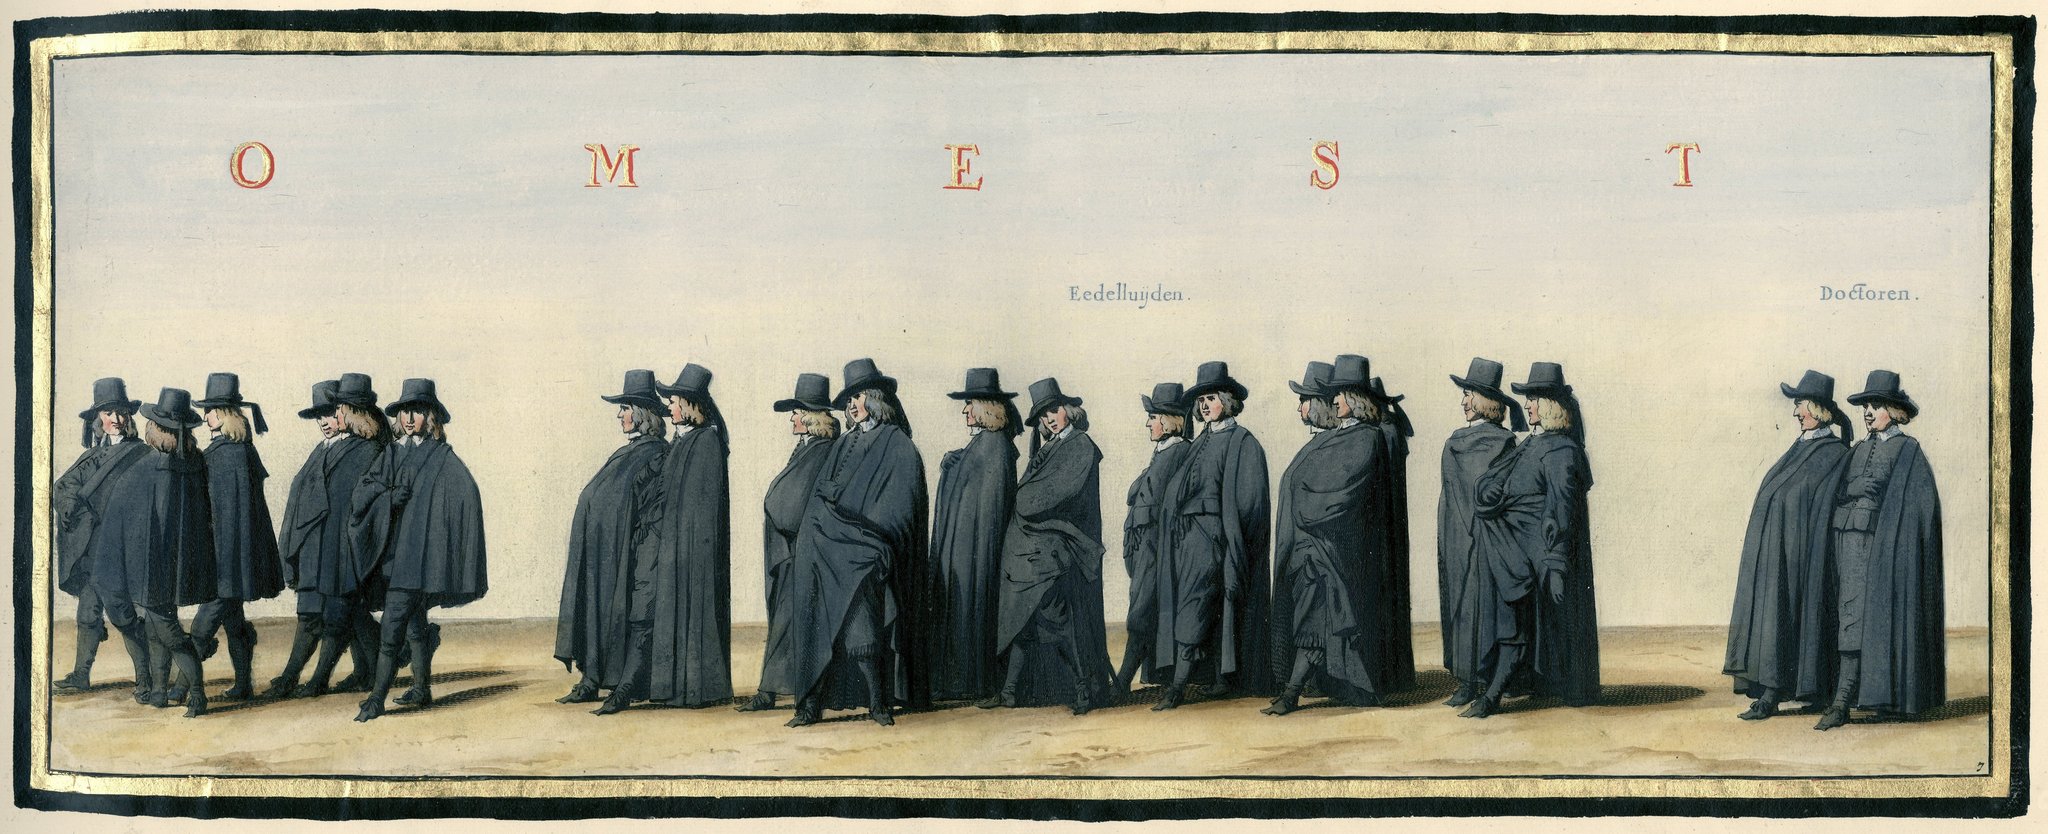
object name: print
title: Begraeffenisse van syne hoogheyt Frederick Henrick. Luxe ingekleurde uitgave van de prenten van de begrafenisstoet van Frederik Hendrik in 1647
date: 1651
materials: paint, paper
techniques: colour, etching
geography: amsterdam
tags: delft, the hague, frederick henry (prince of orange)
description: De begrafenisstoet van Frederik Hendrik, plaat nr. 7. Ingekleurde prent in een omlijsting versierd met goud en ingeplakt in de luxe editie uit ca. 1755 van het boek 'Begraeffenisse van syne hoogheyt Frederick Henrick' van Pieter Post, uitgegeven te Amsterdam in 1651.